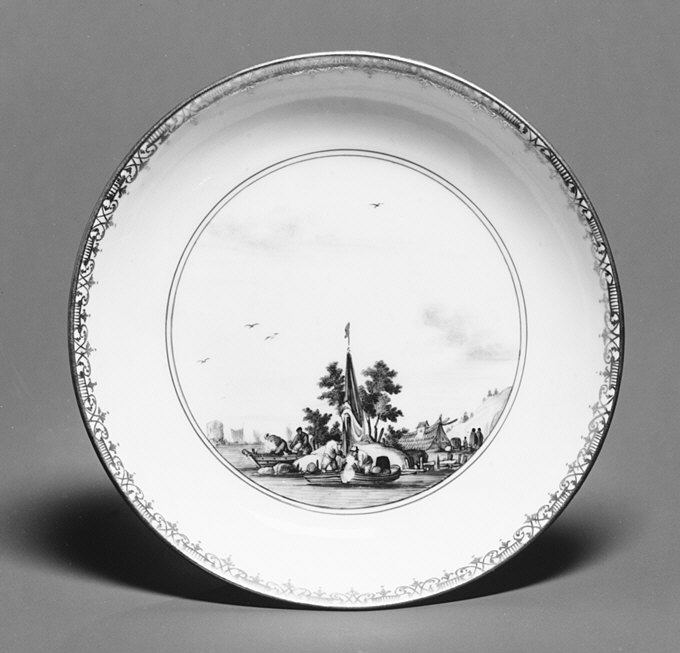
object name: saucer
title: Saucer (part of a service)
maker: meissen manufactory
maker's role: manufactory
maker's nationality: german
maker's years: 1710-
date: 1701-1800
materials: hard paste porcelain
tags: human figures,houses,trees,boats